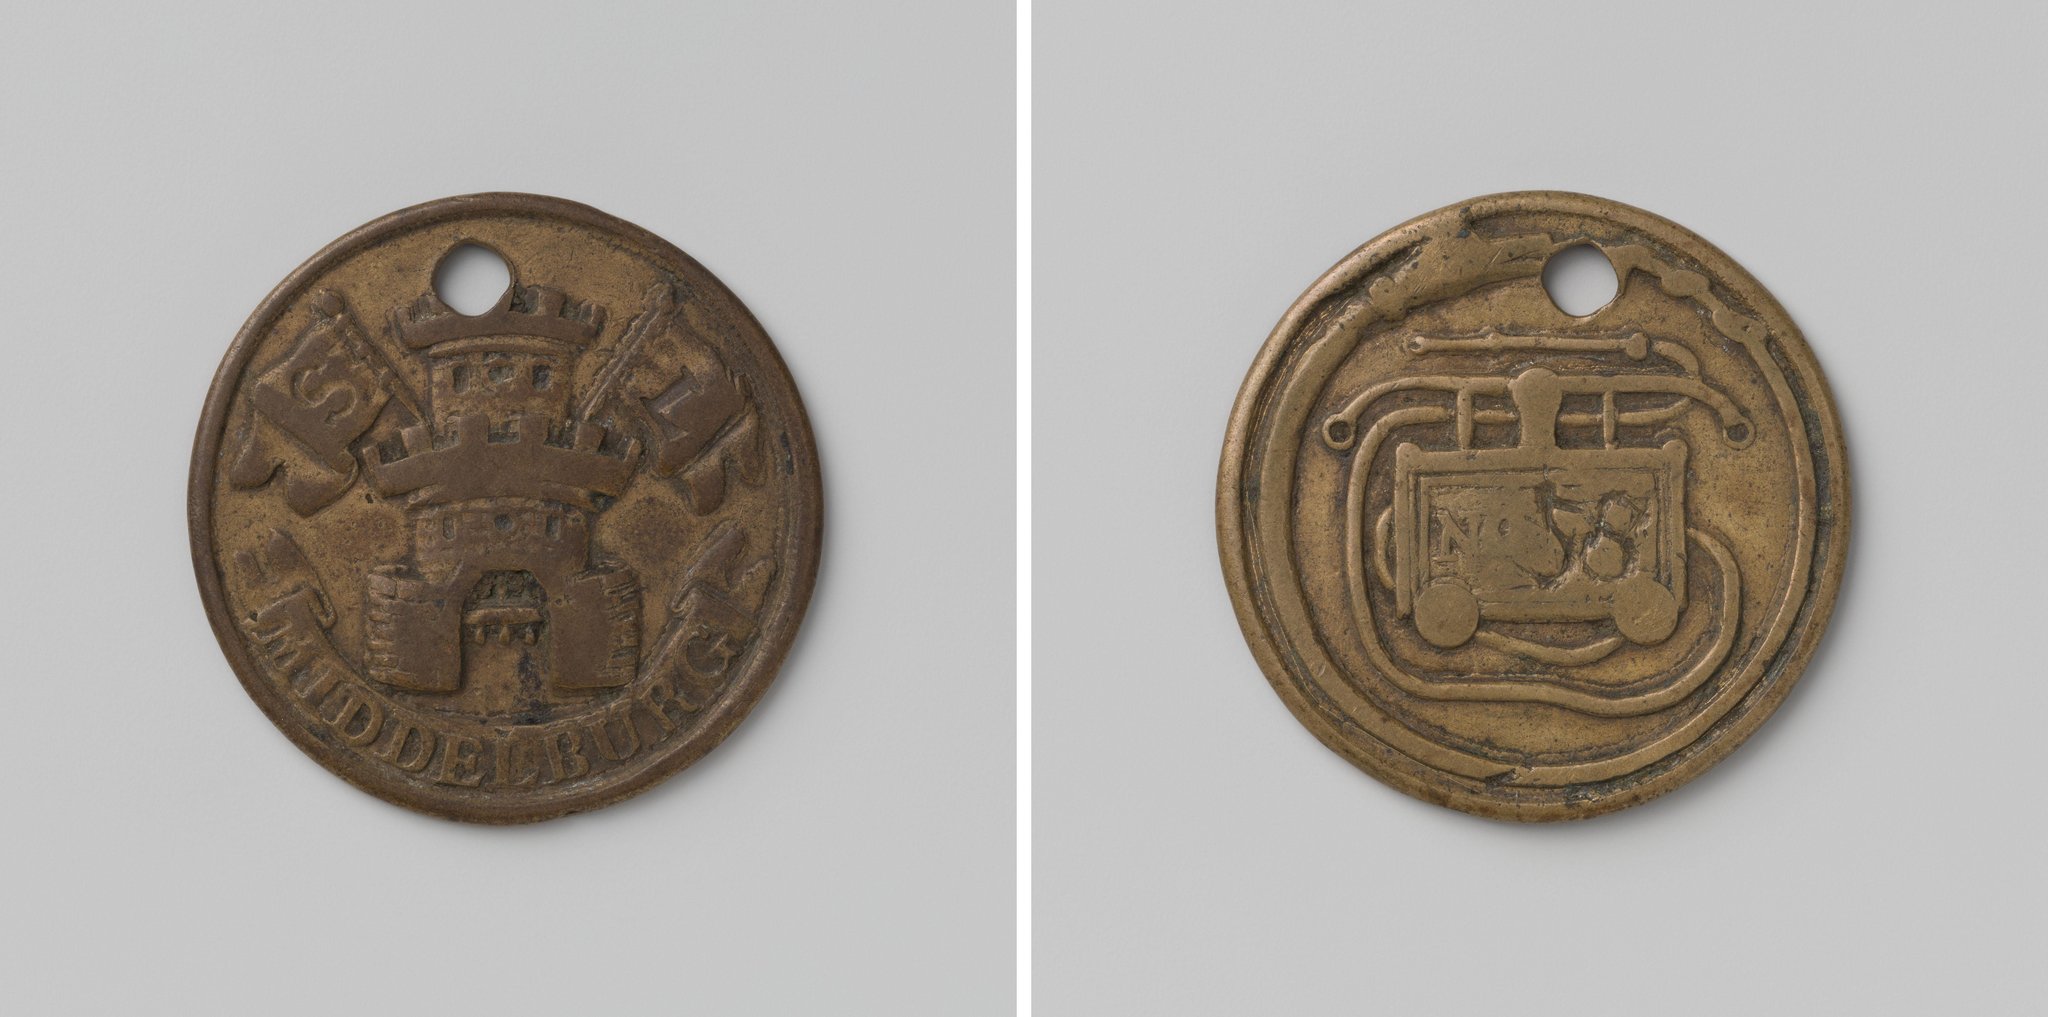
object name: medal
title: Middelburg, brandspuitpenning met no. 58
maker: Anonymous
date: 1680-1800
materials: brass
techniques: casting, engraving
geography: middelburg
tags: middelburg